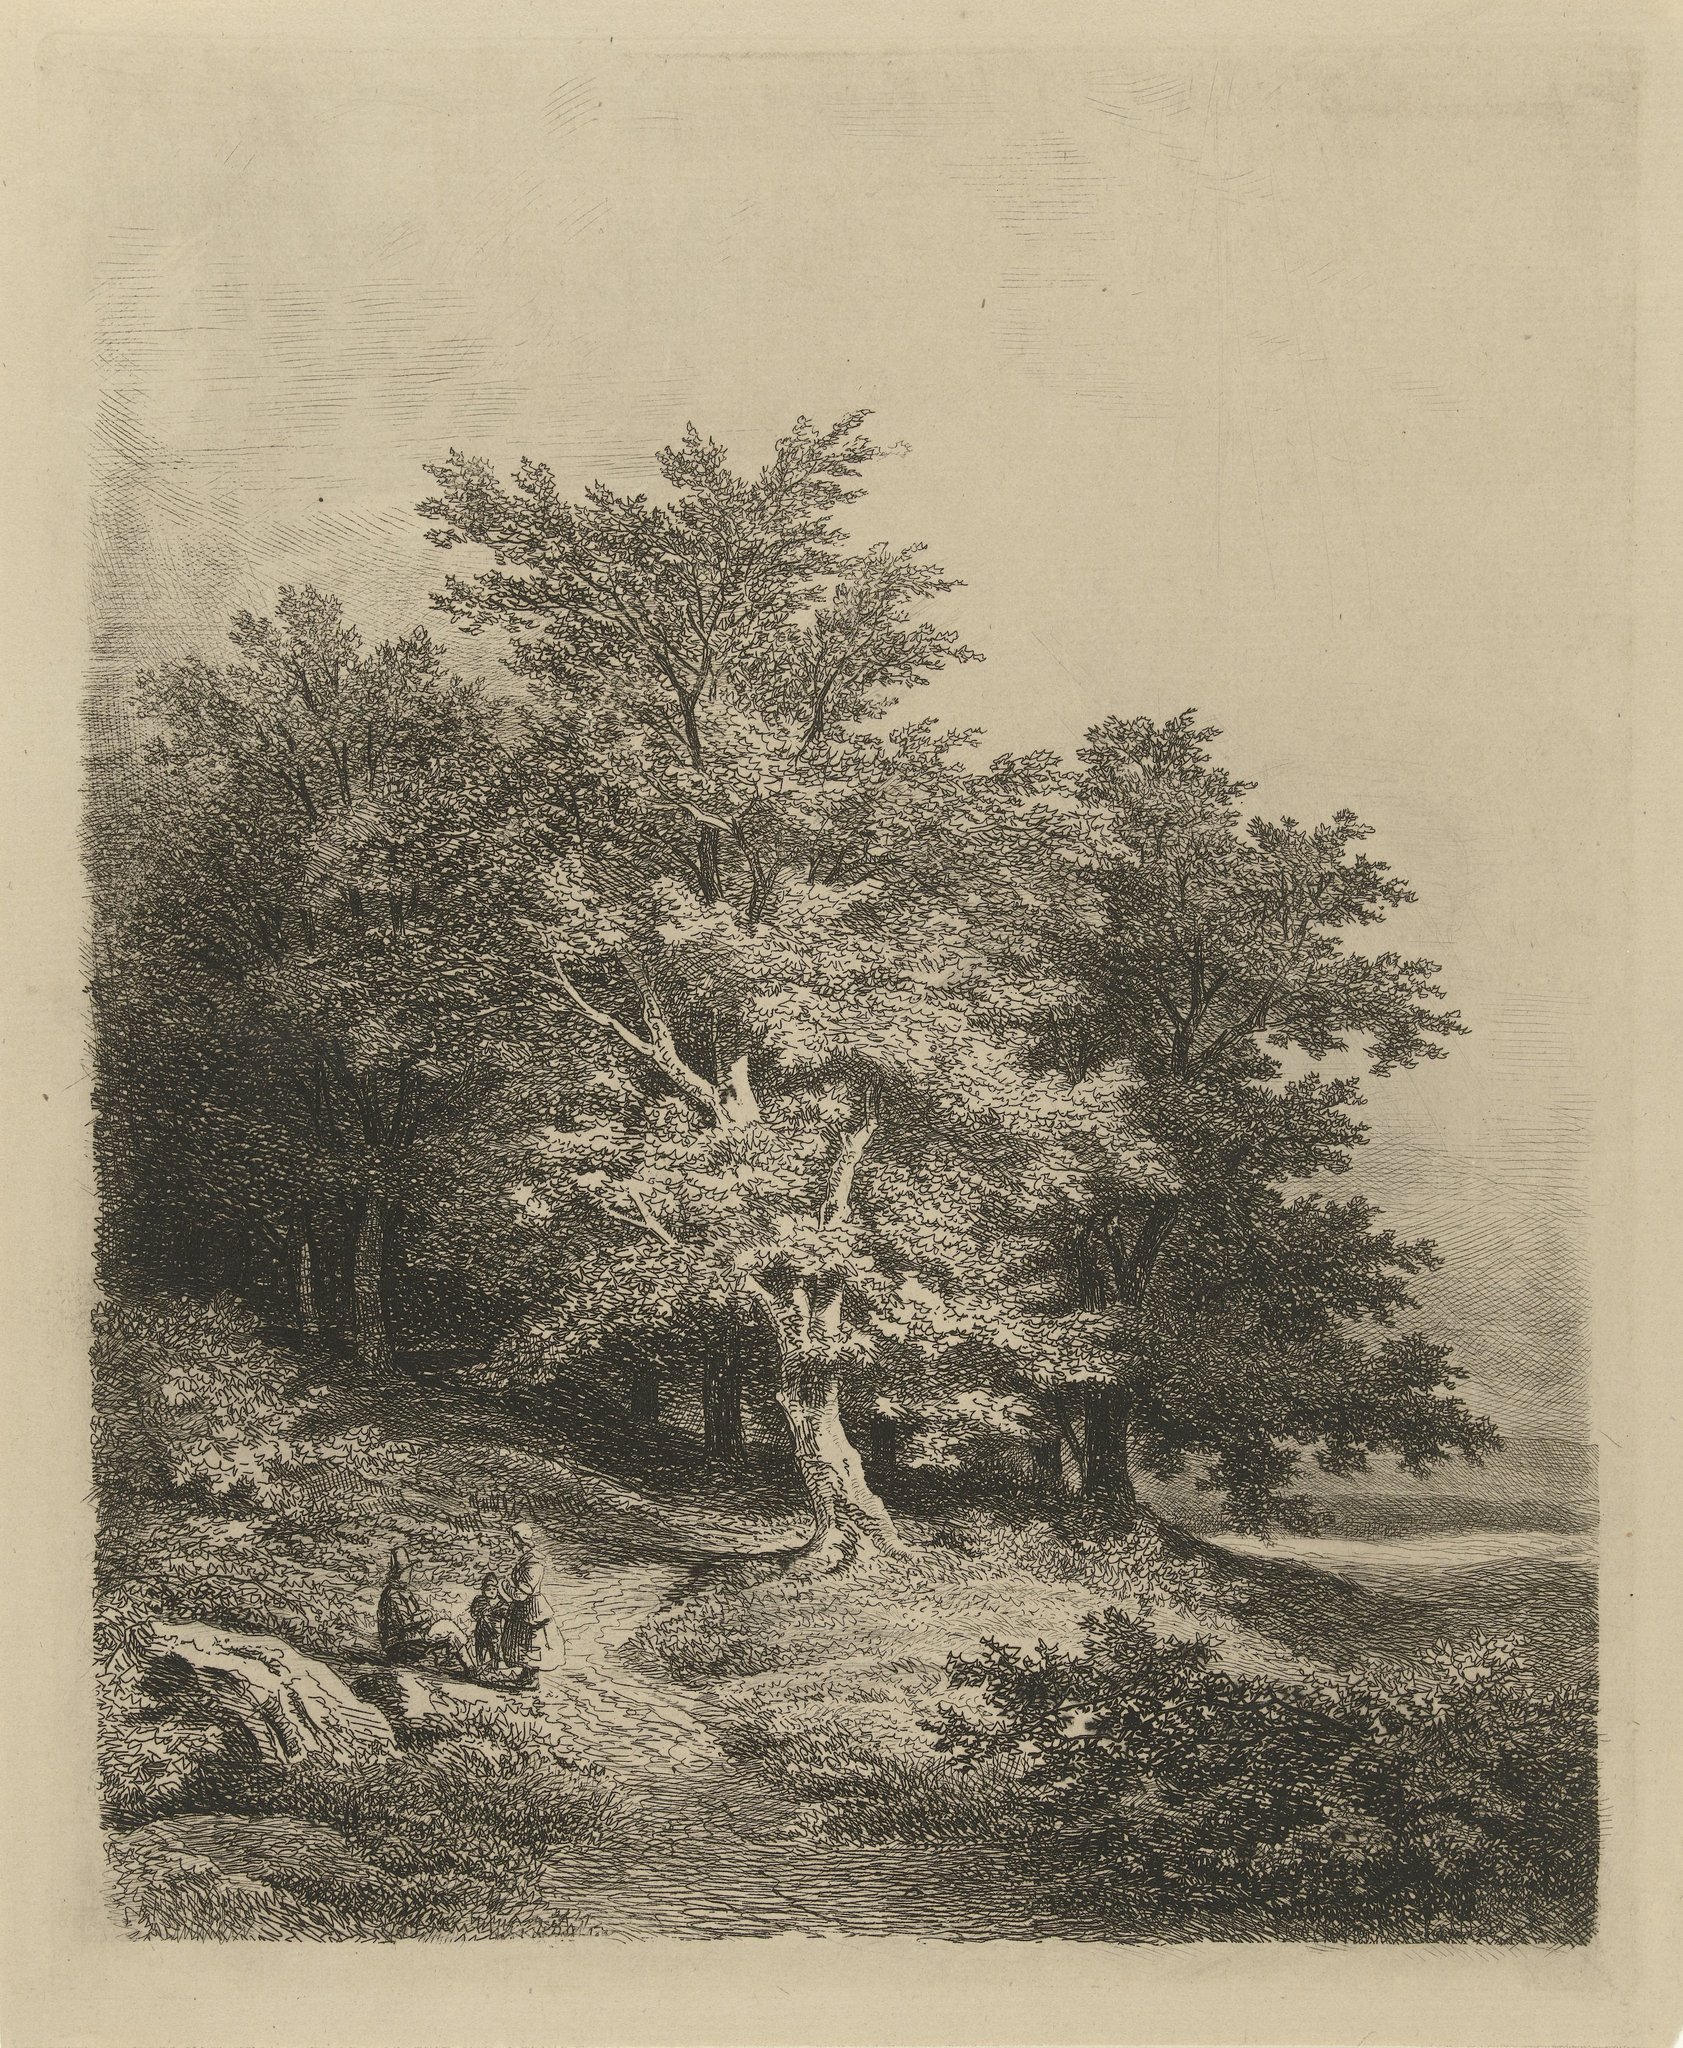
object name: print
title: Figuren bij een bosrand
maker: remigius adrianus haanen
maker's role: draughtsman, painter, print maker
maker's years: 1812-1894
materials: paper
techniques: etching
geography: austria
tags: landscapes (+ landscape with figures, staffage)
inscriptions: collector's mark: Lugt 2228